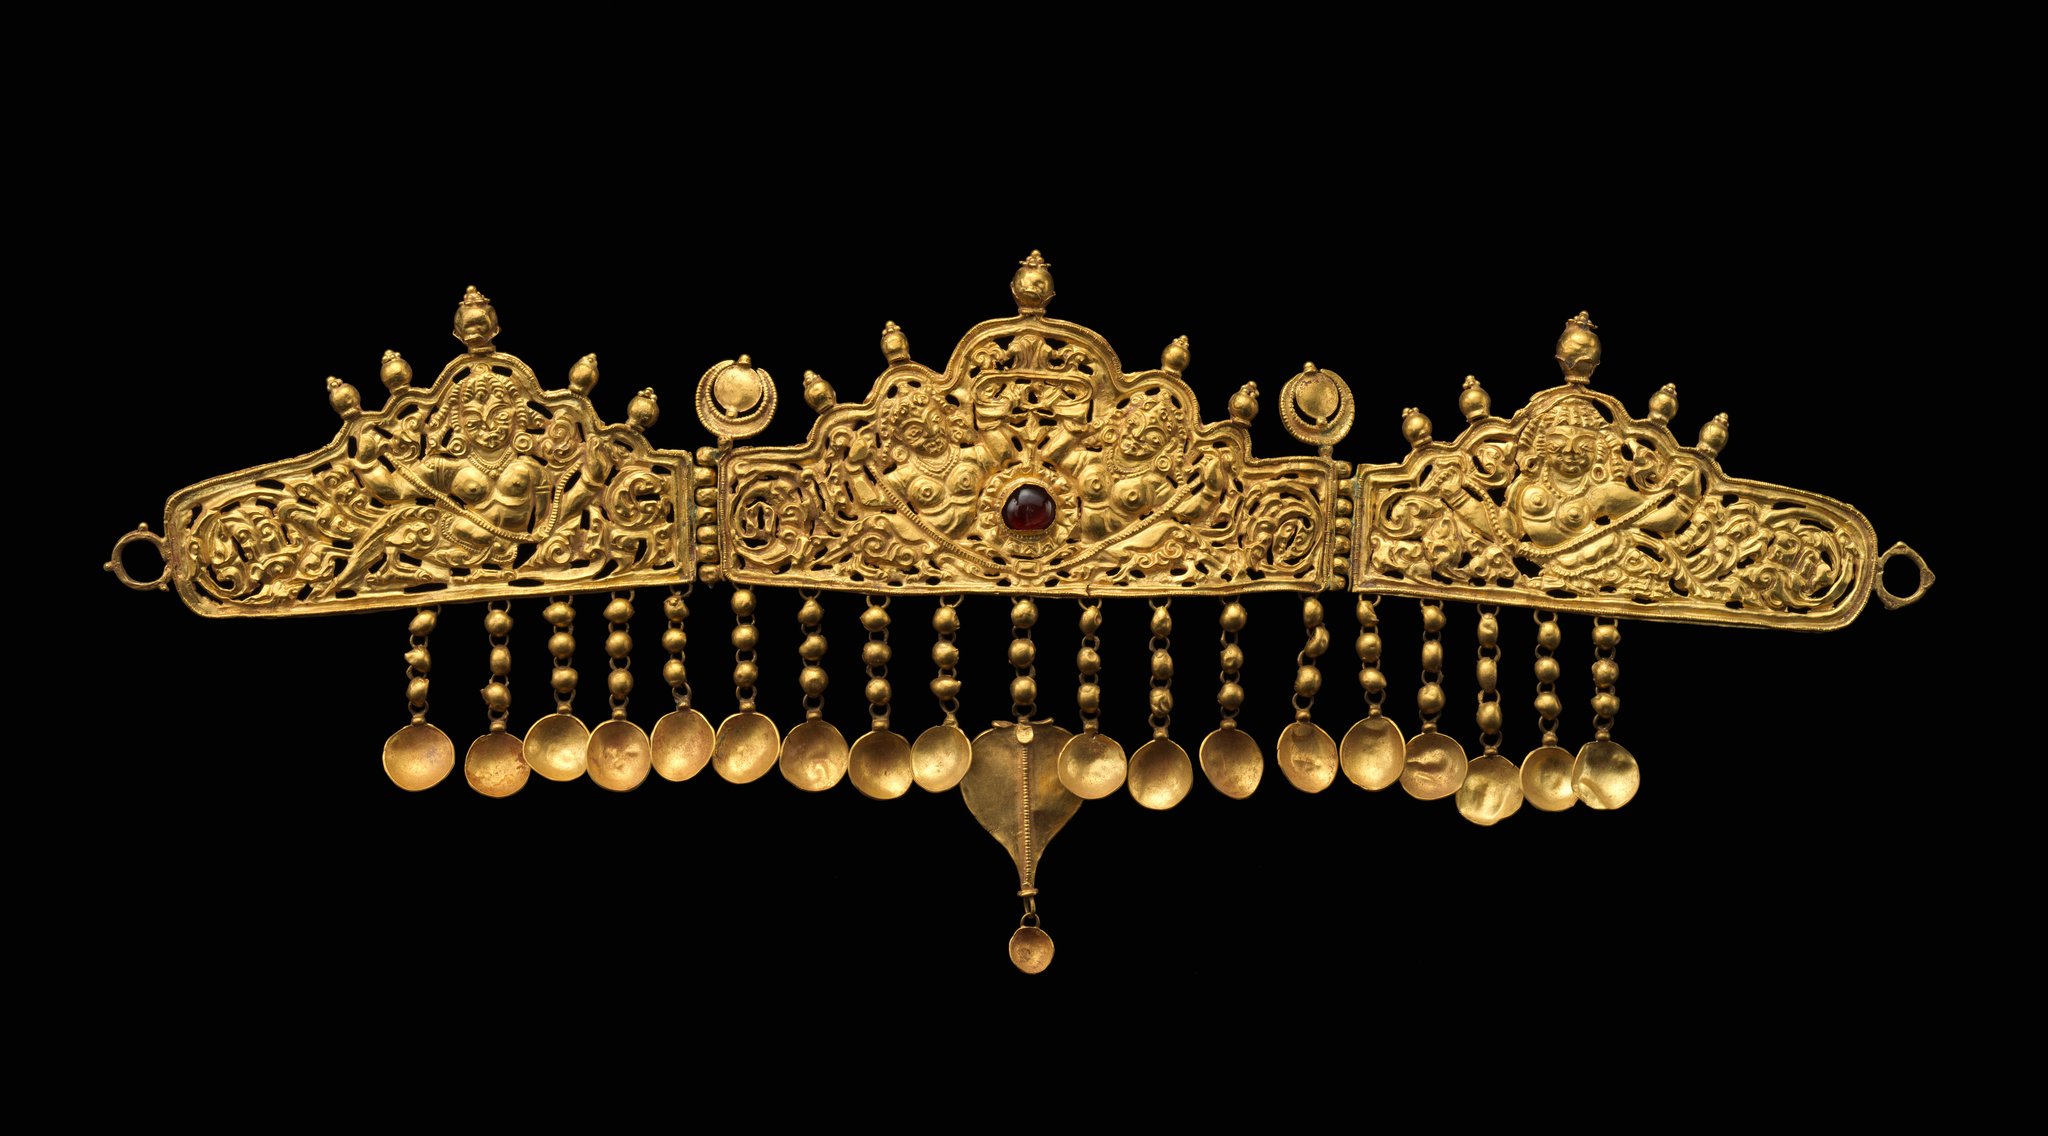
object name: diadem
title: Diadem with Kinnaris (Half-Bird, Half-Female Creatures)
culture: kashmiri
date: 801-1000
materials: gemstone, gold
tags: kashmir,mythical creatures